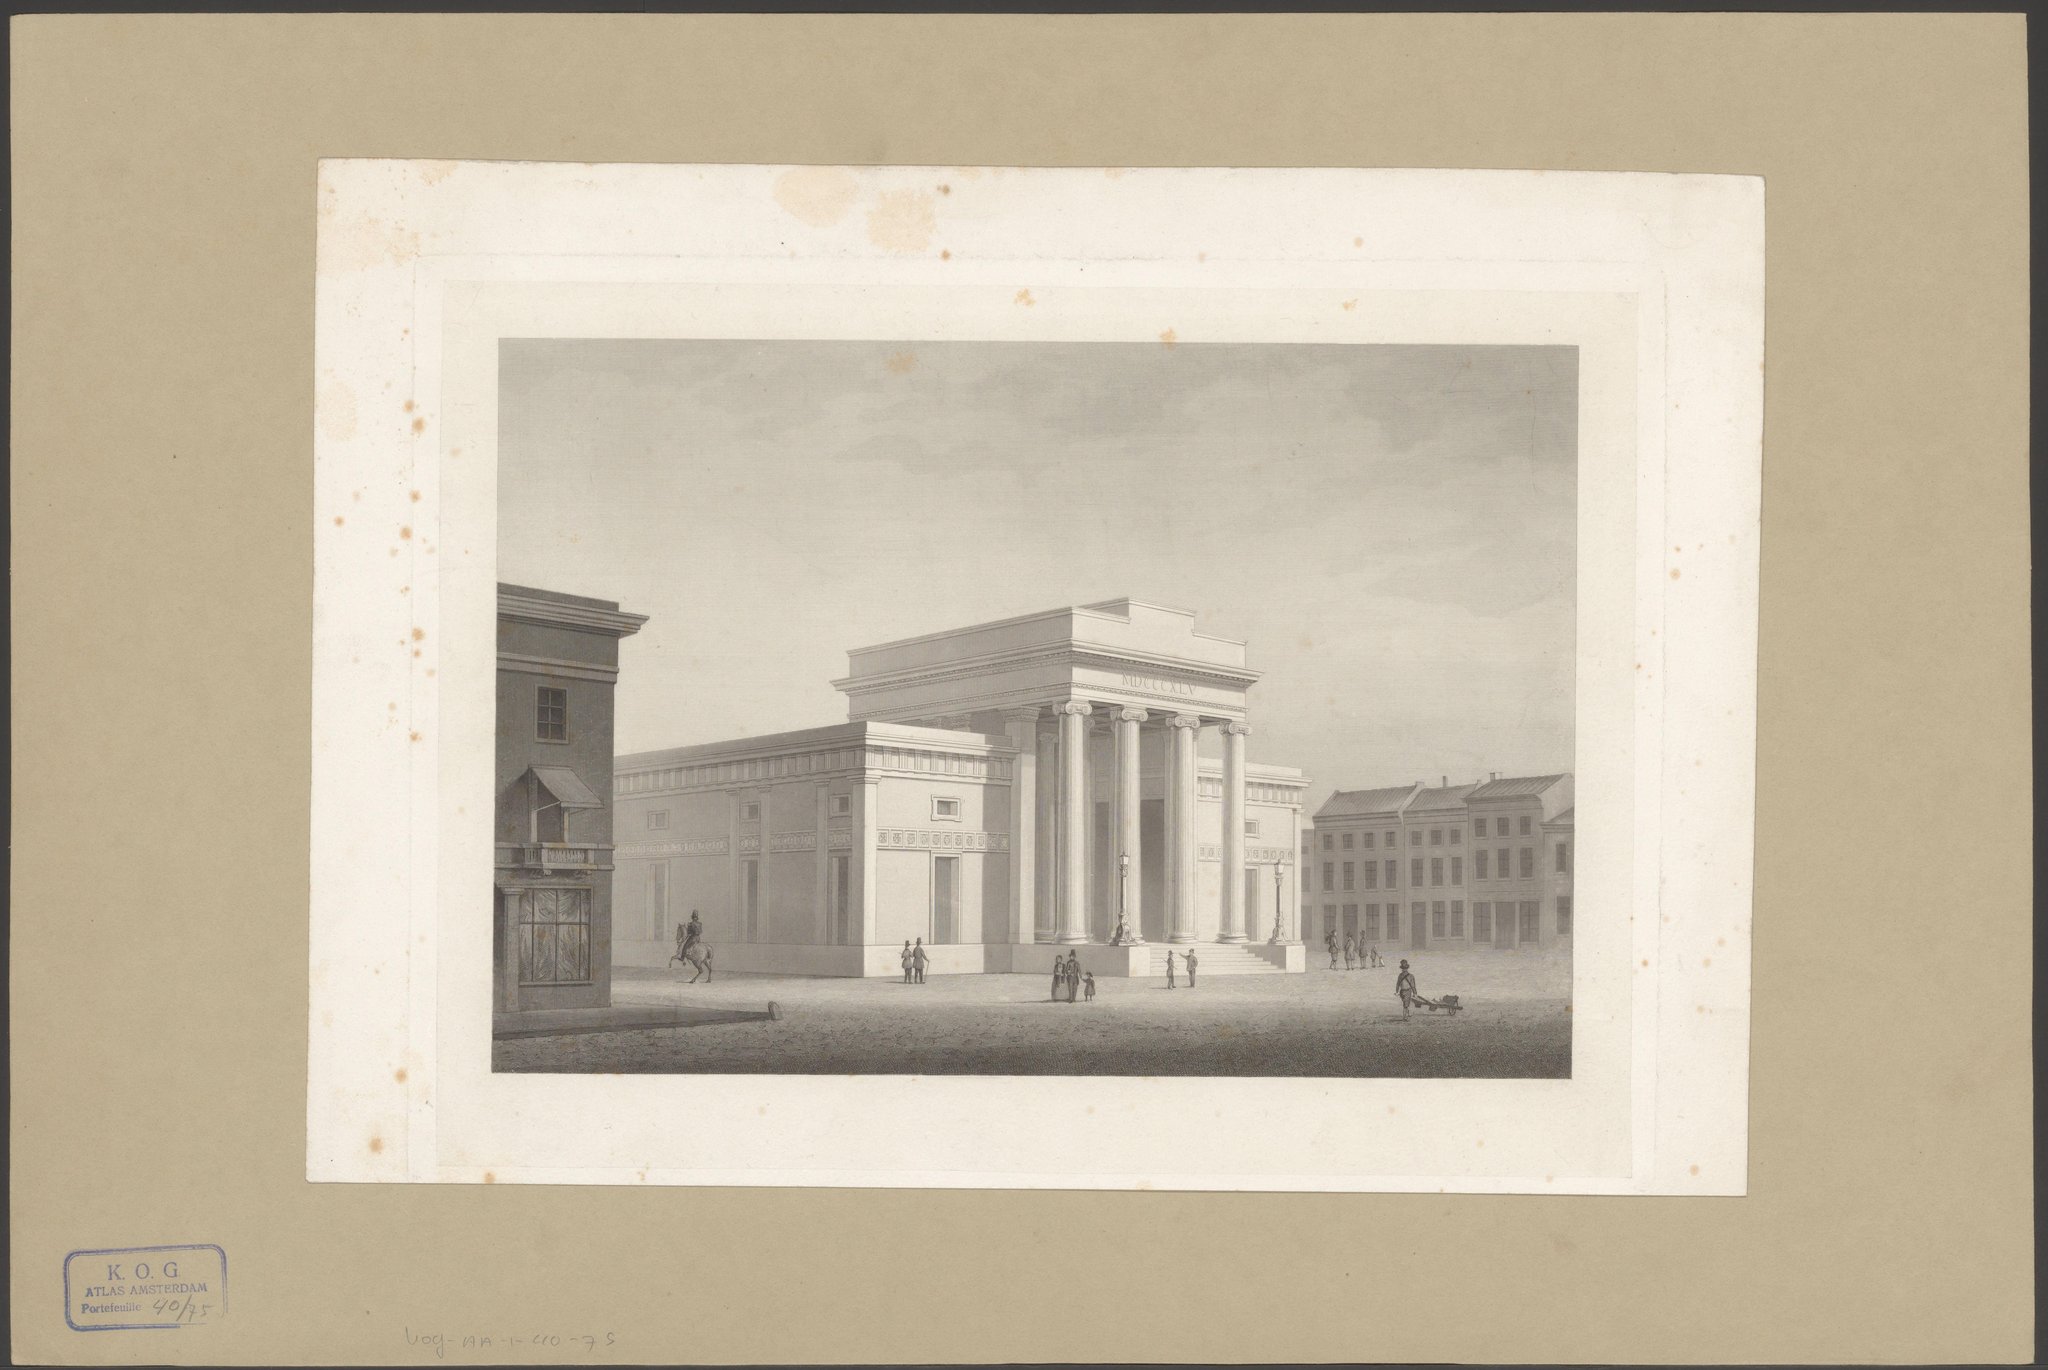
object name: print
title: Gezicht op de Beurs van Zocher te Amsterdam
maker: Anonymous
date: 1845-1847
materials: paper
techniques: engraving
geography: netherlands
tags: stock exchange, stock-market, square, place, circus, etc. (+ city(-scape) with figures, staffage)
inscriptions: collector's mark: Lugt 1641b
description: Onderwerpsrubriek binnen de Atlas Amsterdam: Handel en Zeevaart: Hulpbeurs op de Dam en Beurs (Dam).